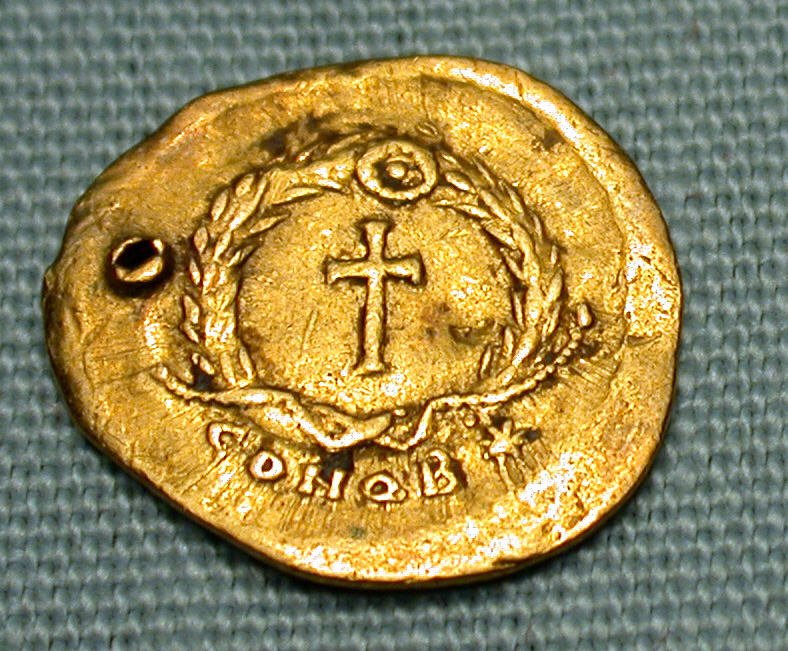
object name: coin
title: Semissis of Aelia Pulcheria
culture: byzantine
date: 415-453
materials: gold